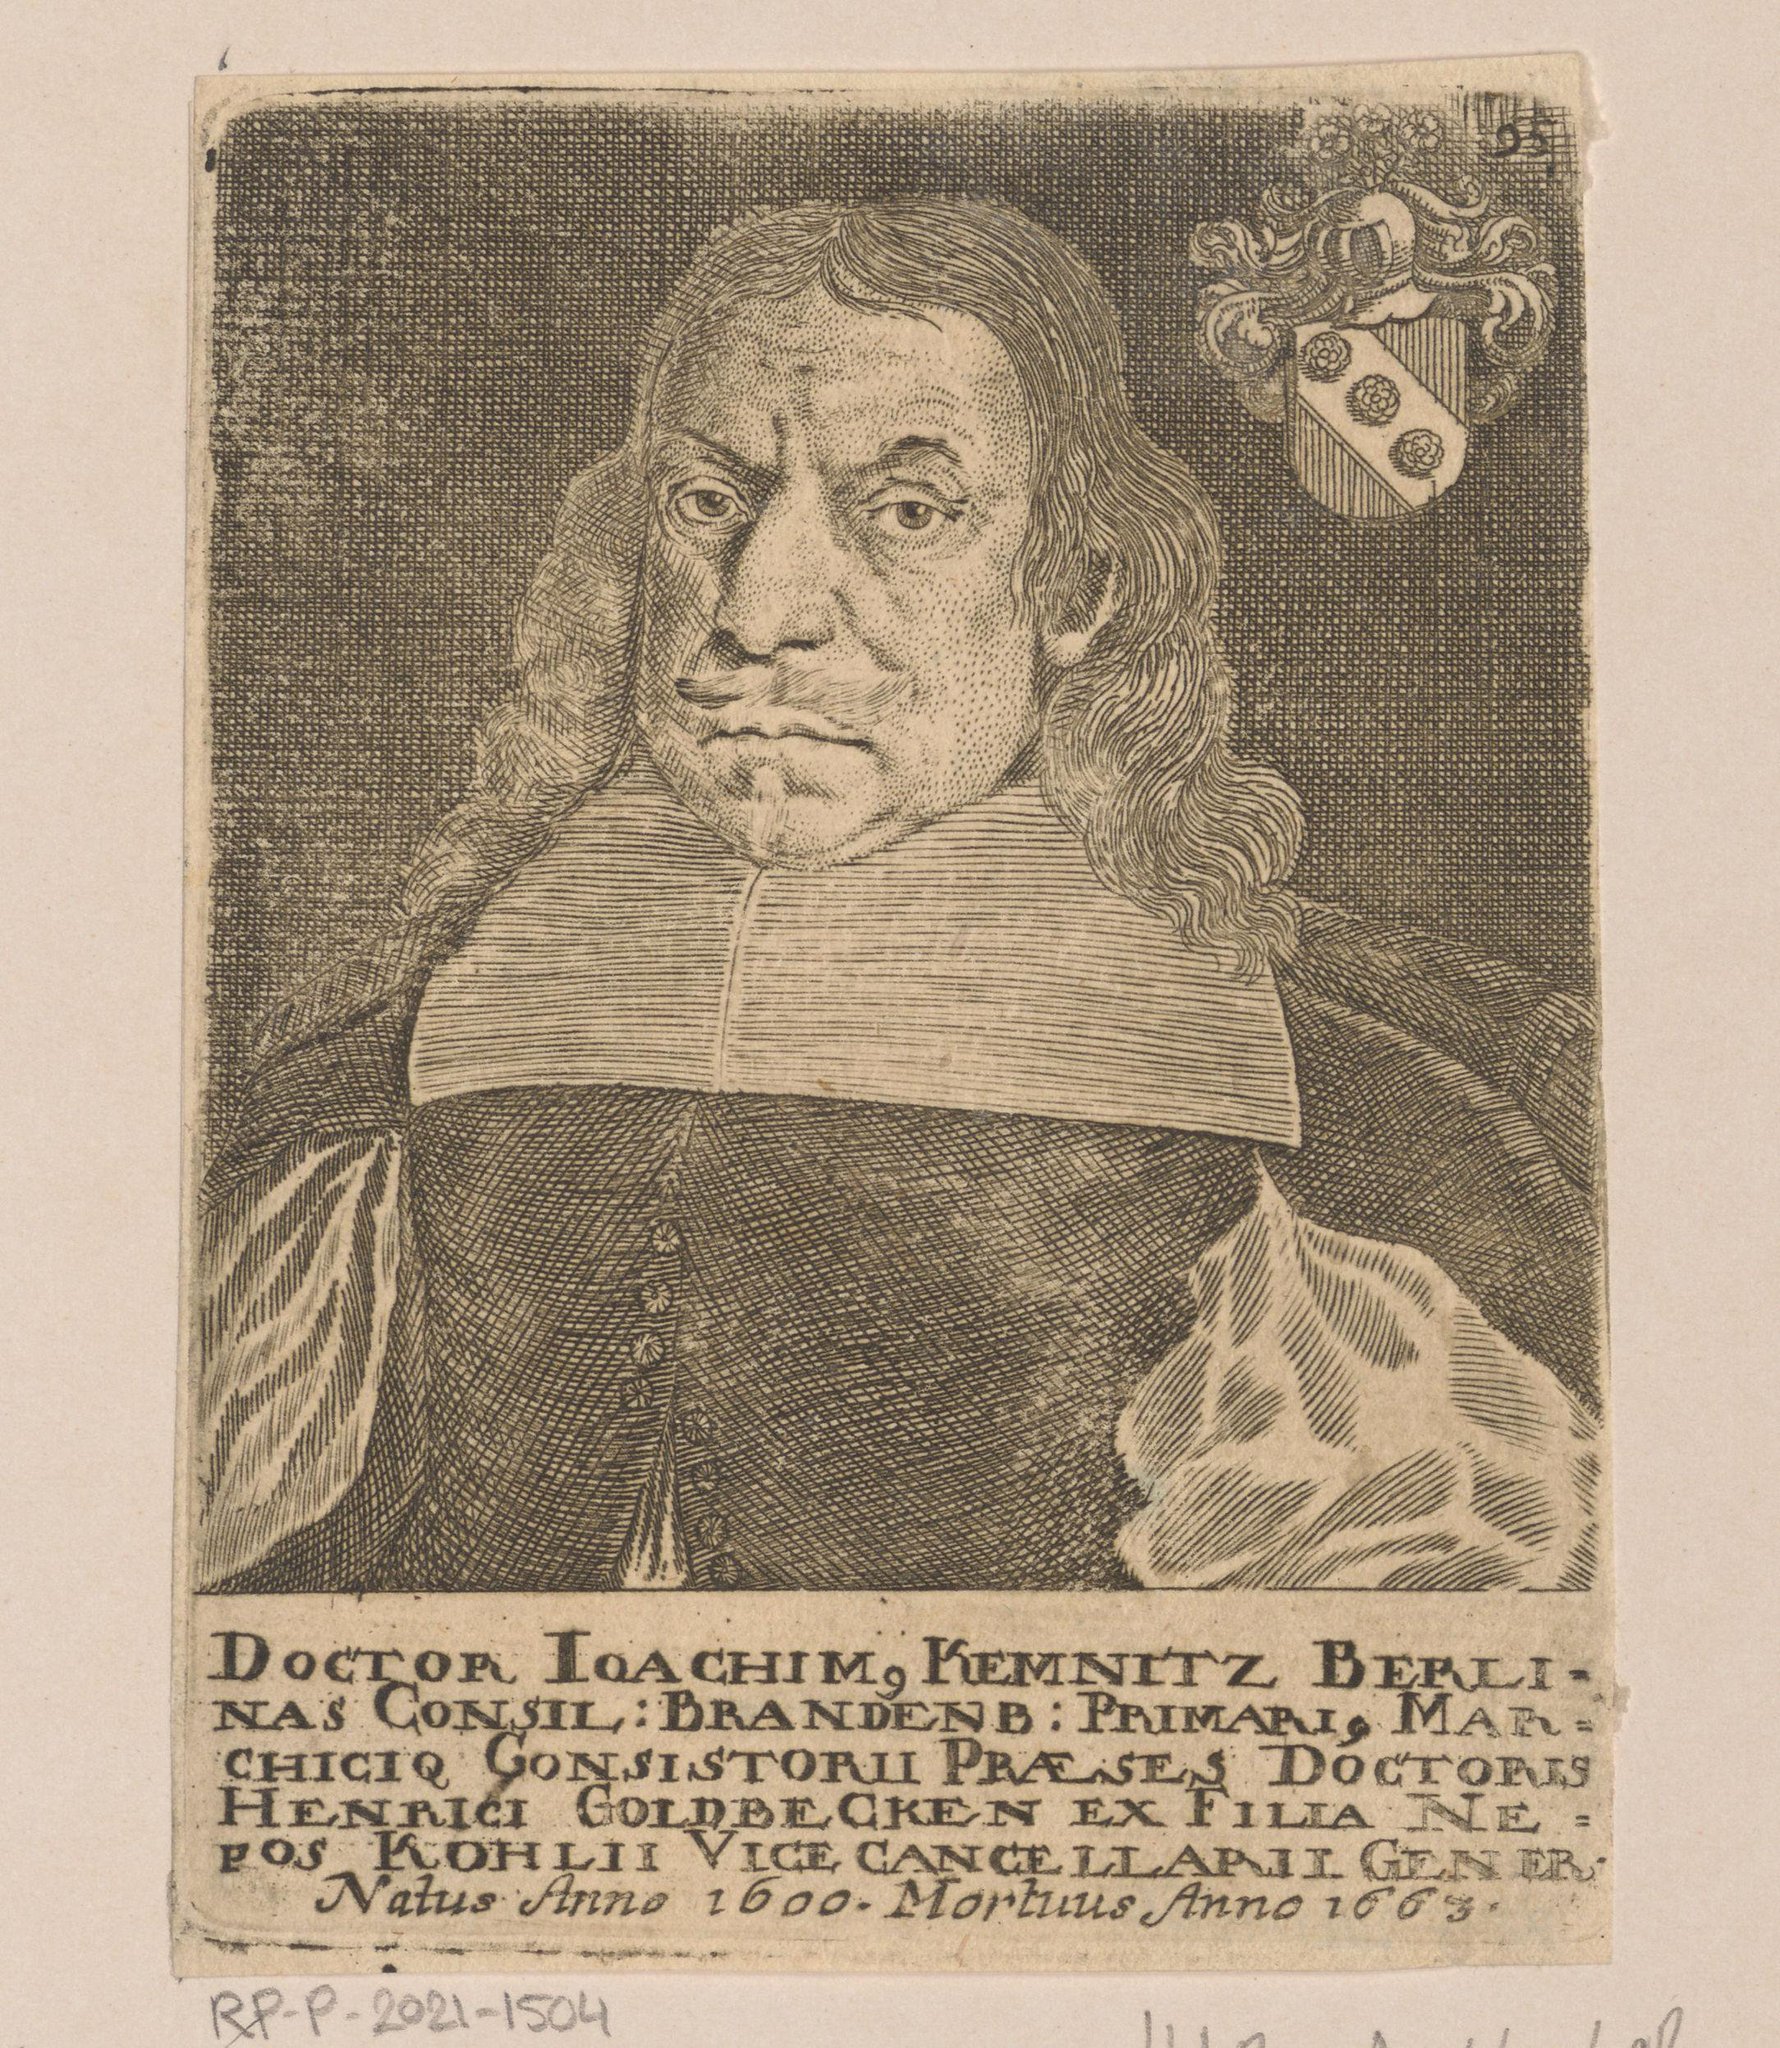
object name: print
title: Portret van Joachim Chemnitz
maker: Anonymous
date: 1751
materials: paper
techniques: engraving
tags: berlin, historical persons, armorial bearing, heraldry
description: Prent mogelijk uit: Küster, Georg Gottfried. Martin Friedrich Seidels Bilder-Sammlung (...). Berlijn: Buchladen bey der Real-Schule, 1751.